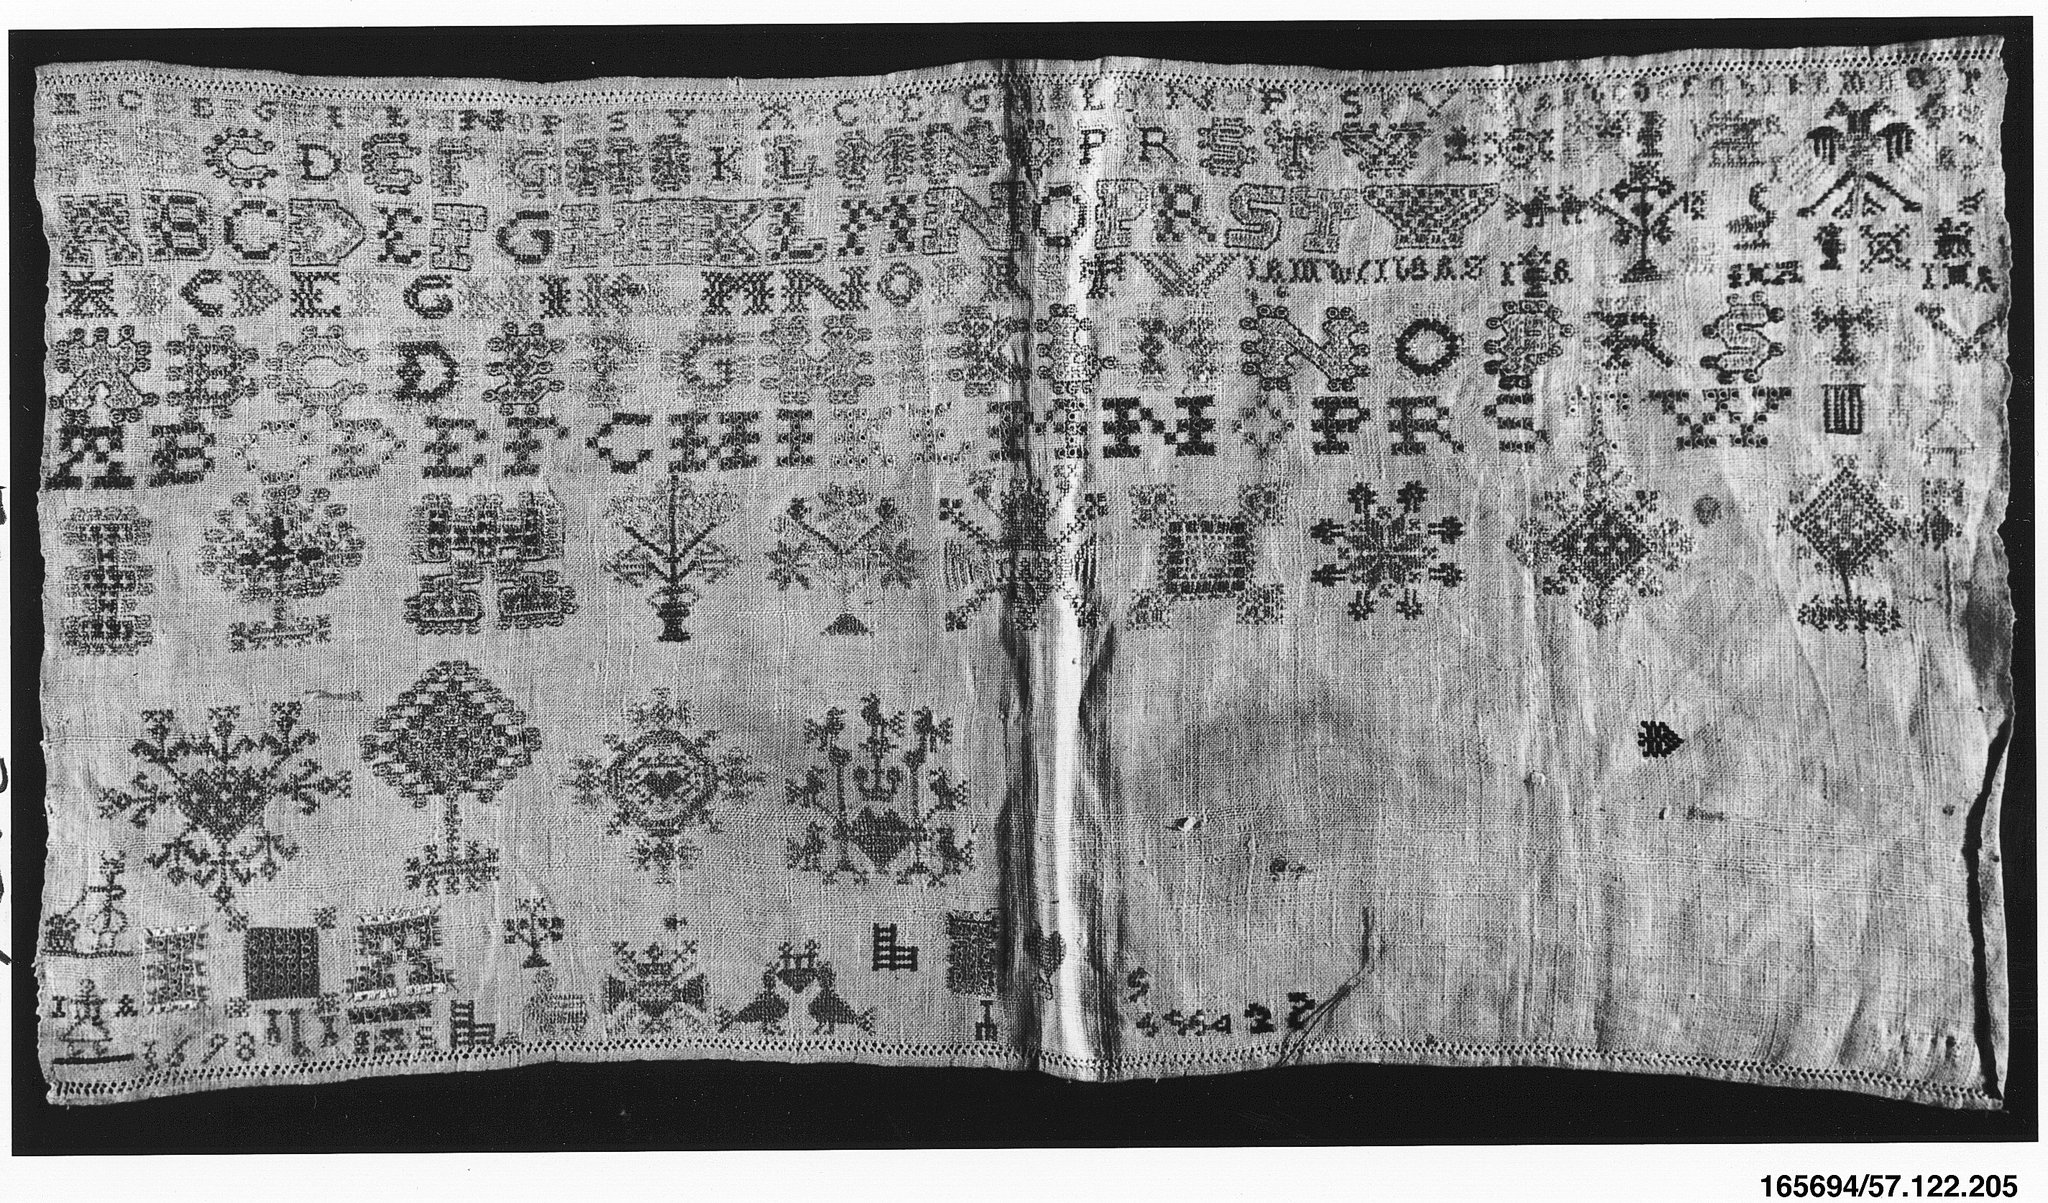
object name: sampler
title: Embroidered sampler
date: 1698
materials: linen, silk